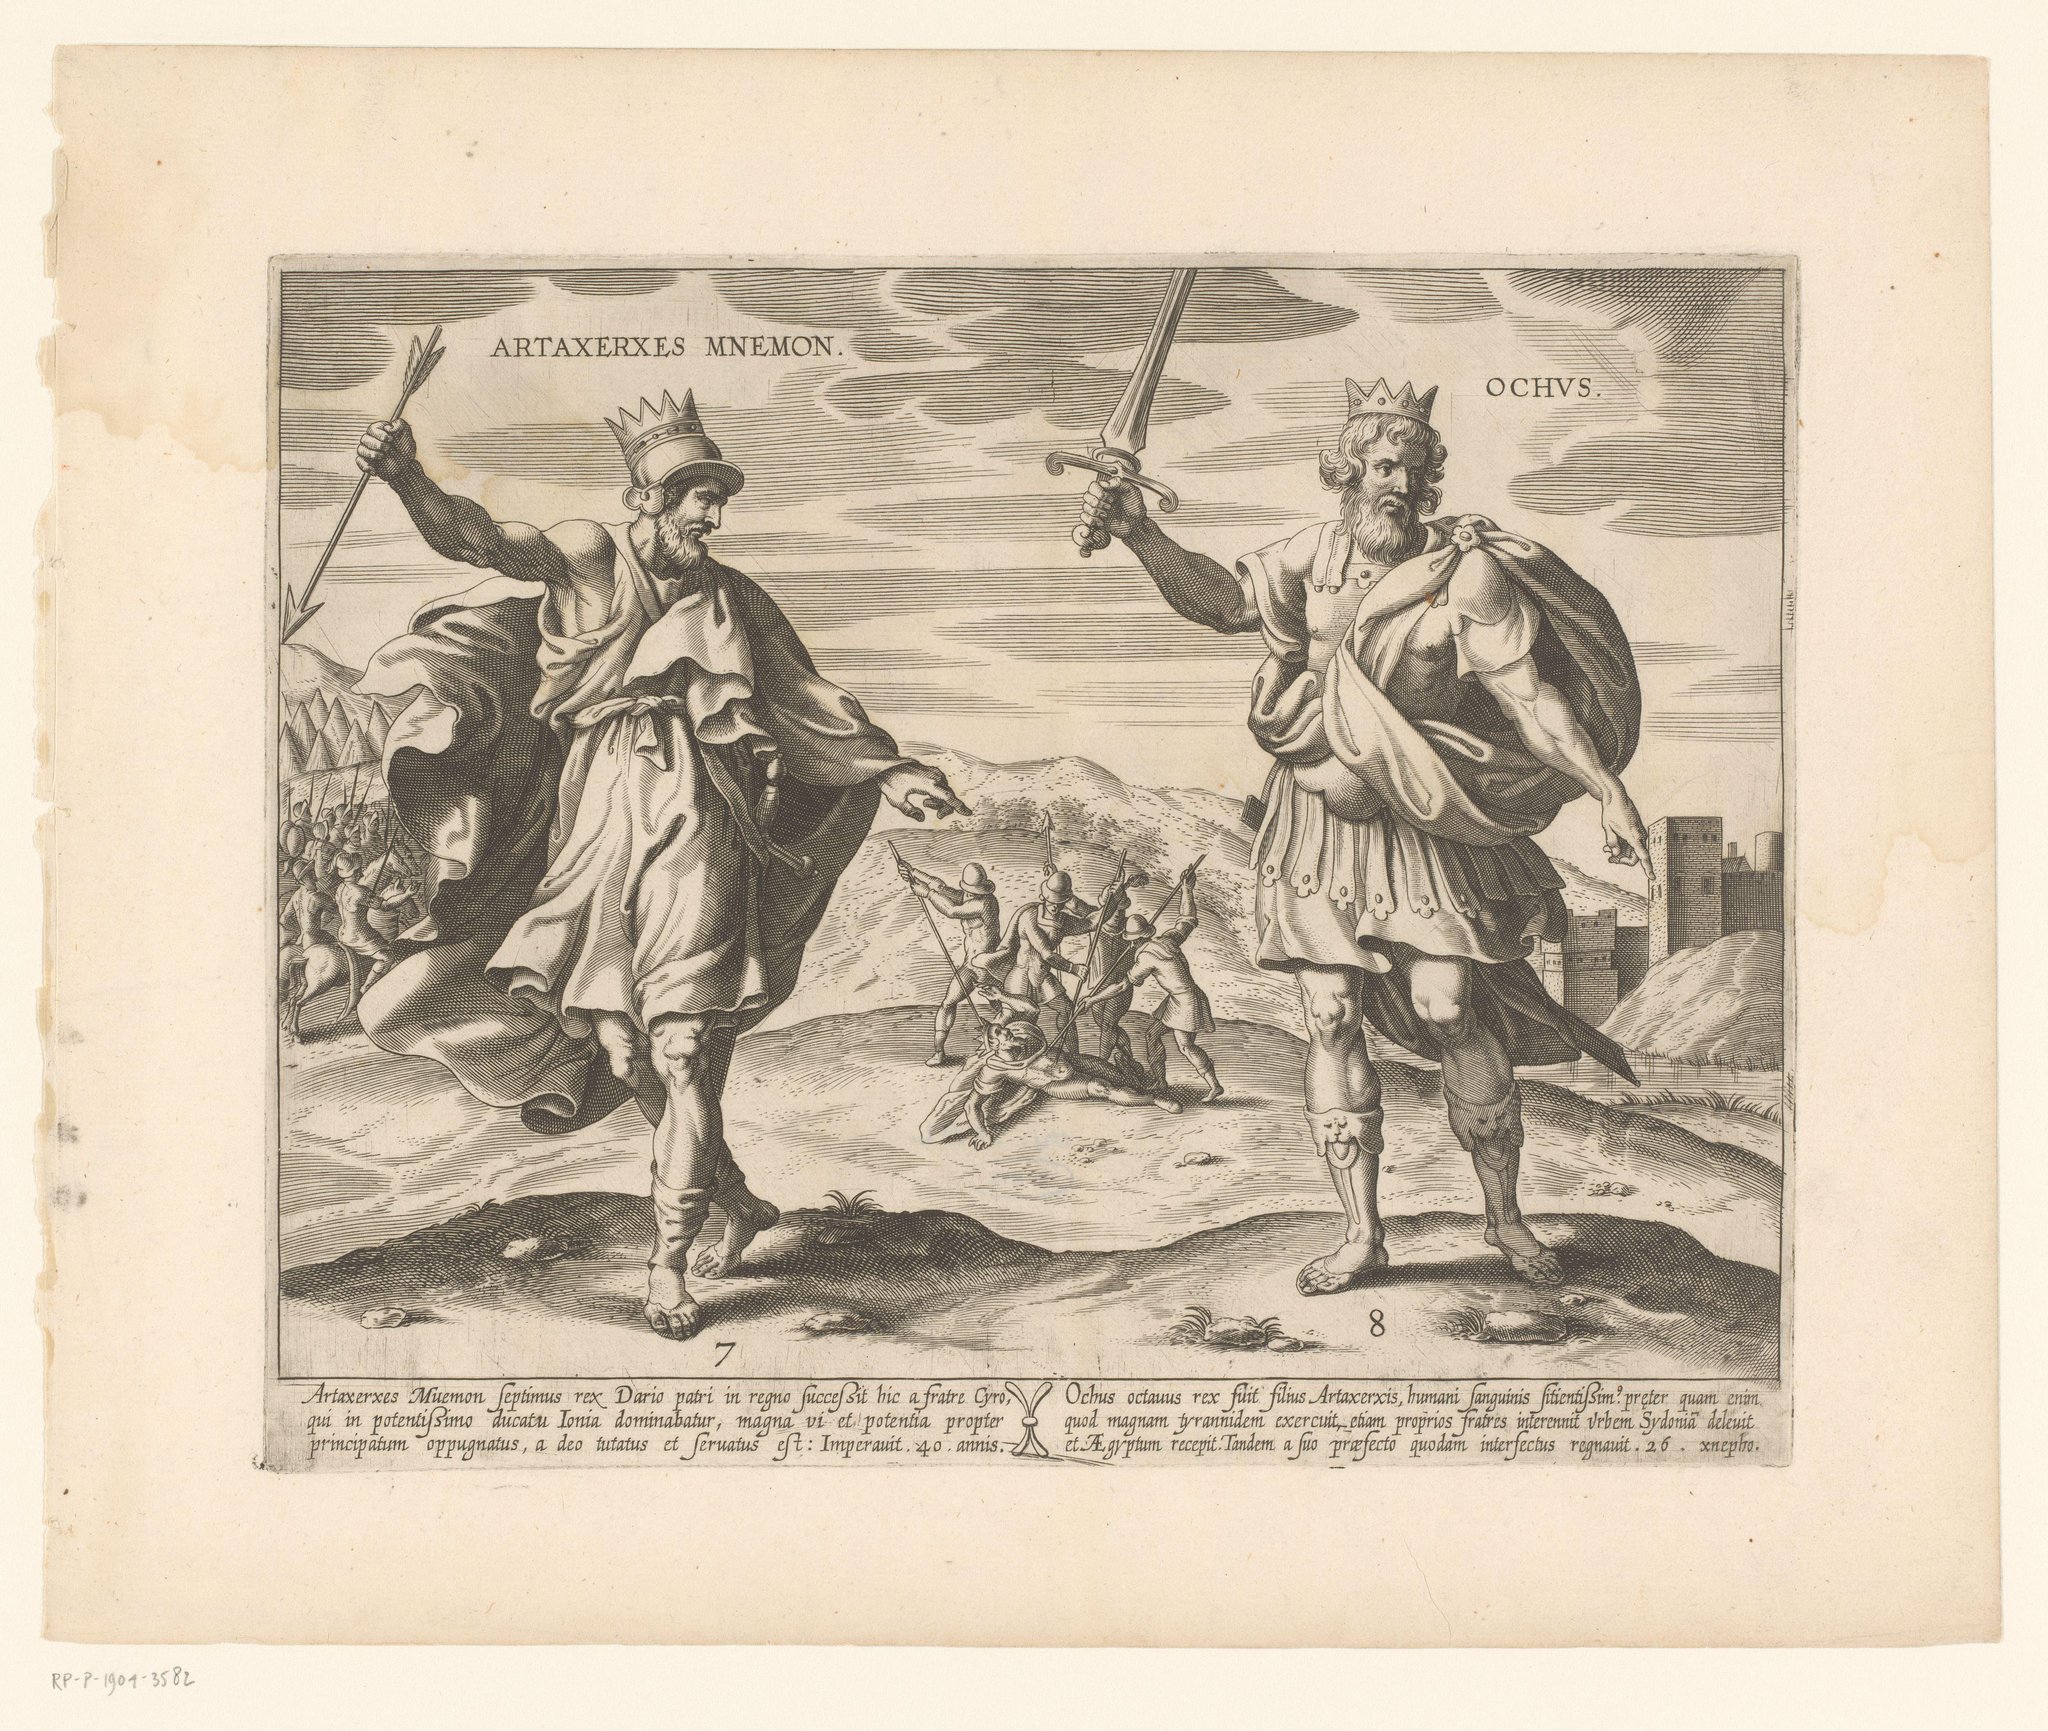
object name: print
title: Perzische koningen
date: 1643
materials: paper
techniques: engraving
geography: amsterdam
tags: battle, murder, ruler, sovereign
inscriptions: collector's mark: Lugt 2228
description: Links koning Artaxerxes II van Perzië staande met een pijl in zijn hand. Op de achtergrond is te zien hoe Artaxerxes zijn jongere broer Cyrus verslaat, die tegen hem in opstand was gekomen. Rechts koning Artaxerxes III van Perzië staande met een zwaard in zijn hand. Op de achtergrond is vermoedelijk te zien hoe zijn oudere broer wordt geëxecuteerd. Onder de voorstelling verklarende teksten in het Latijn. Deze prent maakt deel uit van een album.